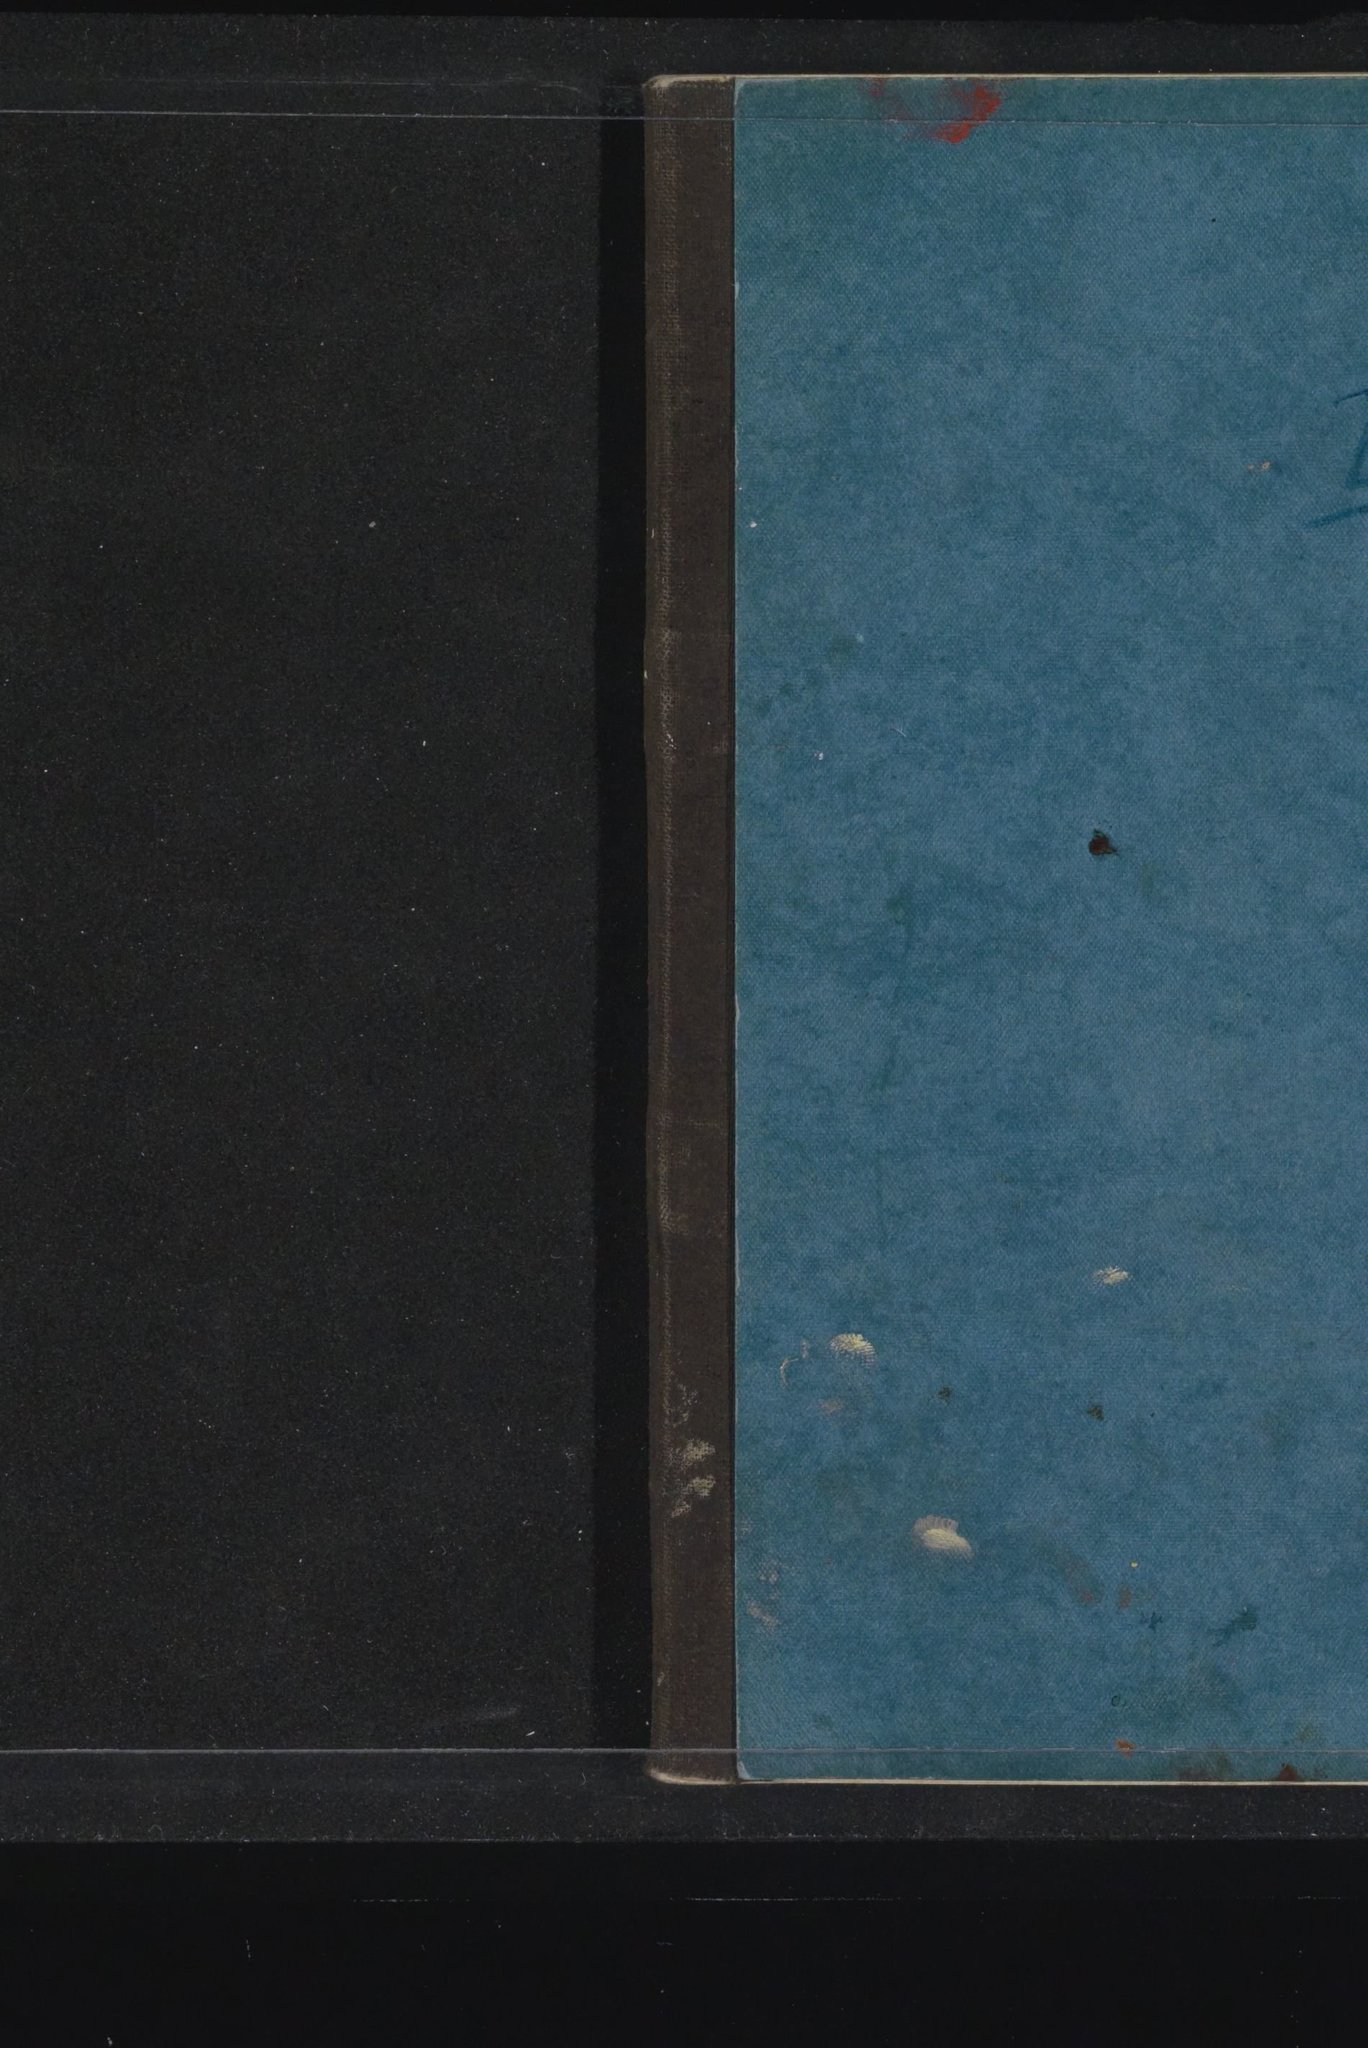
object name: sketchbook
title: Schetsboek LII met 43 bladen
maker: isaac israels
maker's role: draughtsman, painter, print maker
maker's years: 1865-1934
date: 1875-1934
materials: cardboard, chalk, linen, paper, pencil, watercolor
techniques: brush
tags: adult woman, head (human) - aa - female human figure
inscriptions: collector's mark: Lugt 2228, label: ‘Lefranc & Cie / Paris’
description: Bladen 1, 2(V), 3(V), 4(V), 5(V), 6(V) t/m 8(R), 9, 10(V), 10A(R), 11, 12, 14, 15(R), 16(V) t/m 19(R), 23(V), 24, 25(V), 26(V), 27, 28(R), 29(R), 32(V), 33(V), 35(R), 36(V) t/m 37, 38(V) t/m 40(R), 42(R) en 43(R) zijn blanco en daarom niet opgenomen.